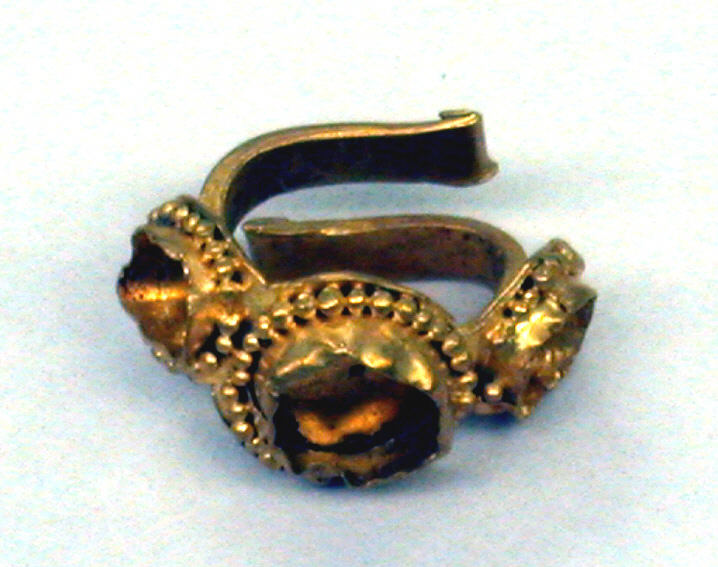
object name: clasp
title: Garment Clasp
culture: visayas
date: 1301-1500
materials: gold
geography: philippines